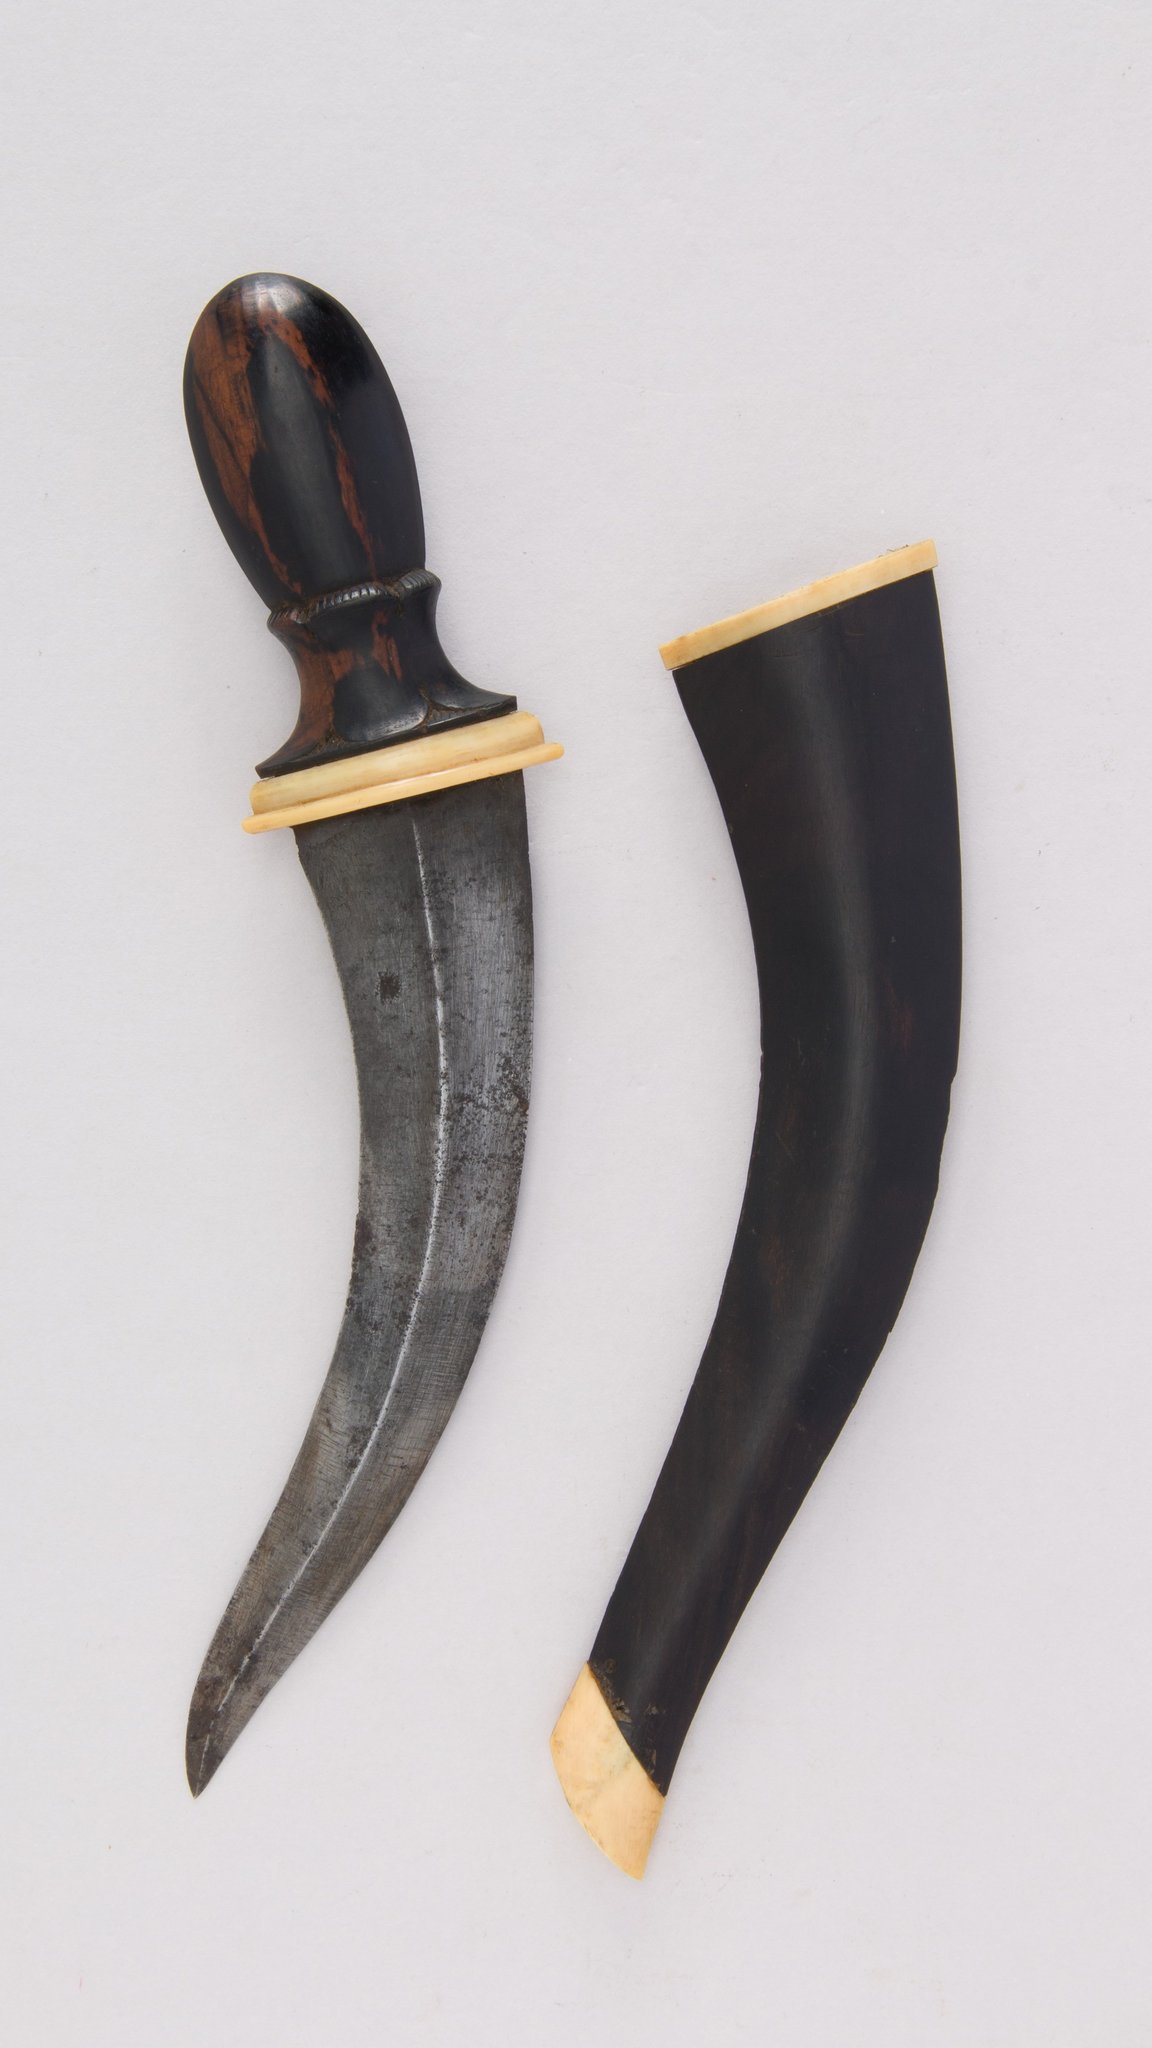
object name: dagger jambiya with sheath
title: Dagger (Jambiya) with Sheath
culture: bornean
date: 1701-1900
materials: bone, steel, wood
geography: borneo